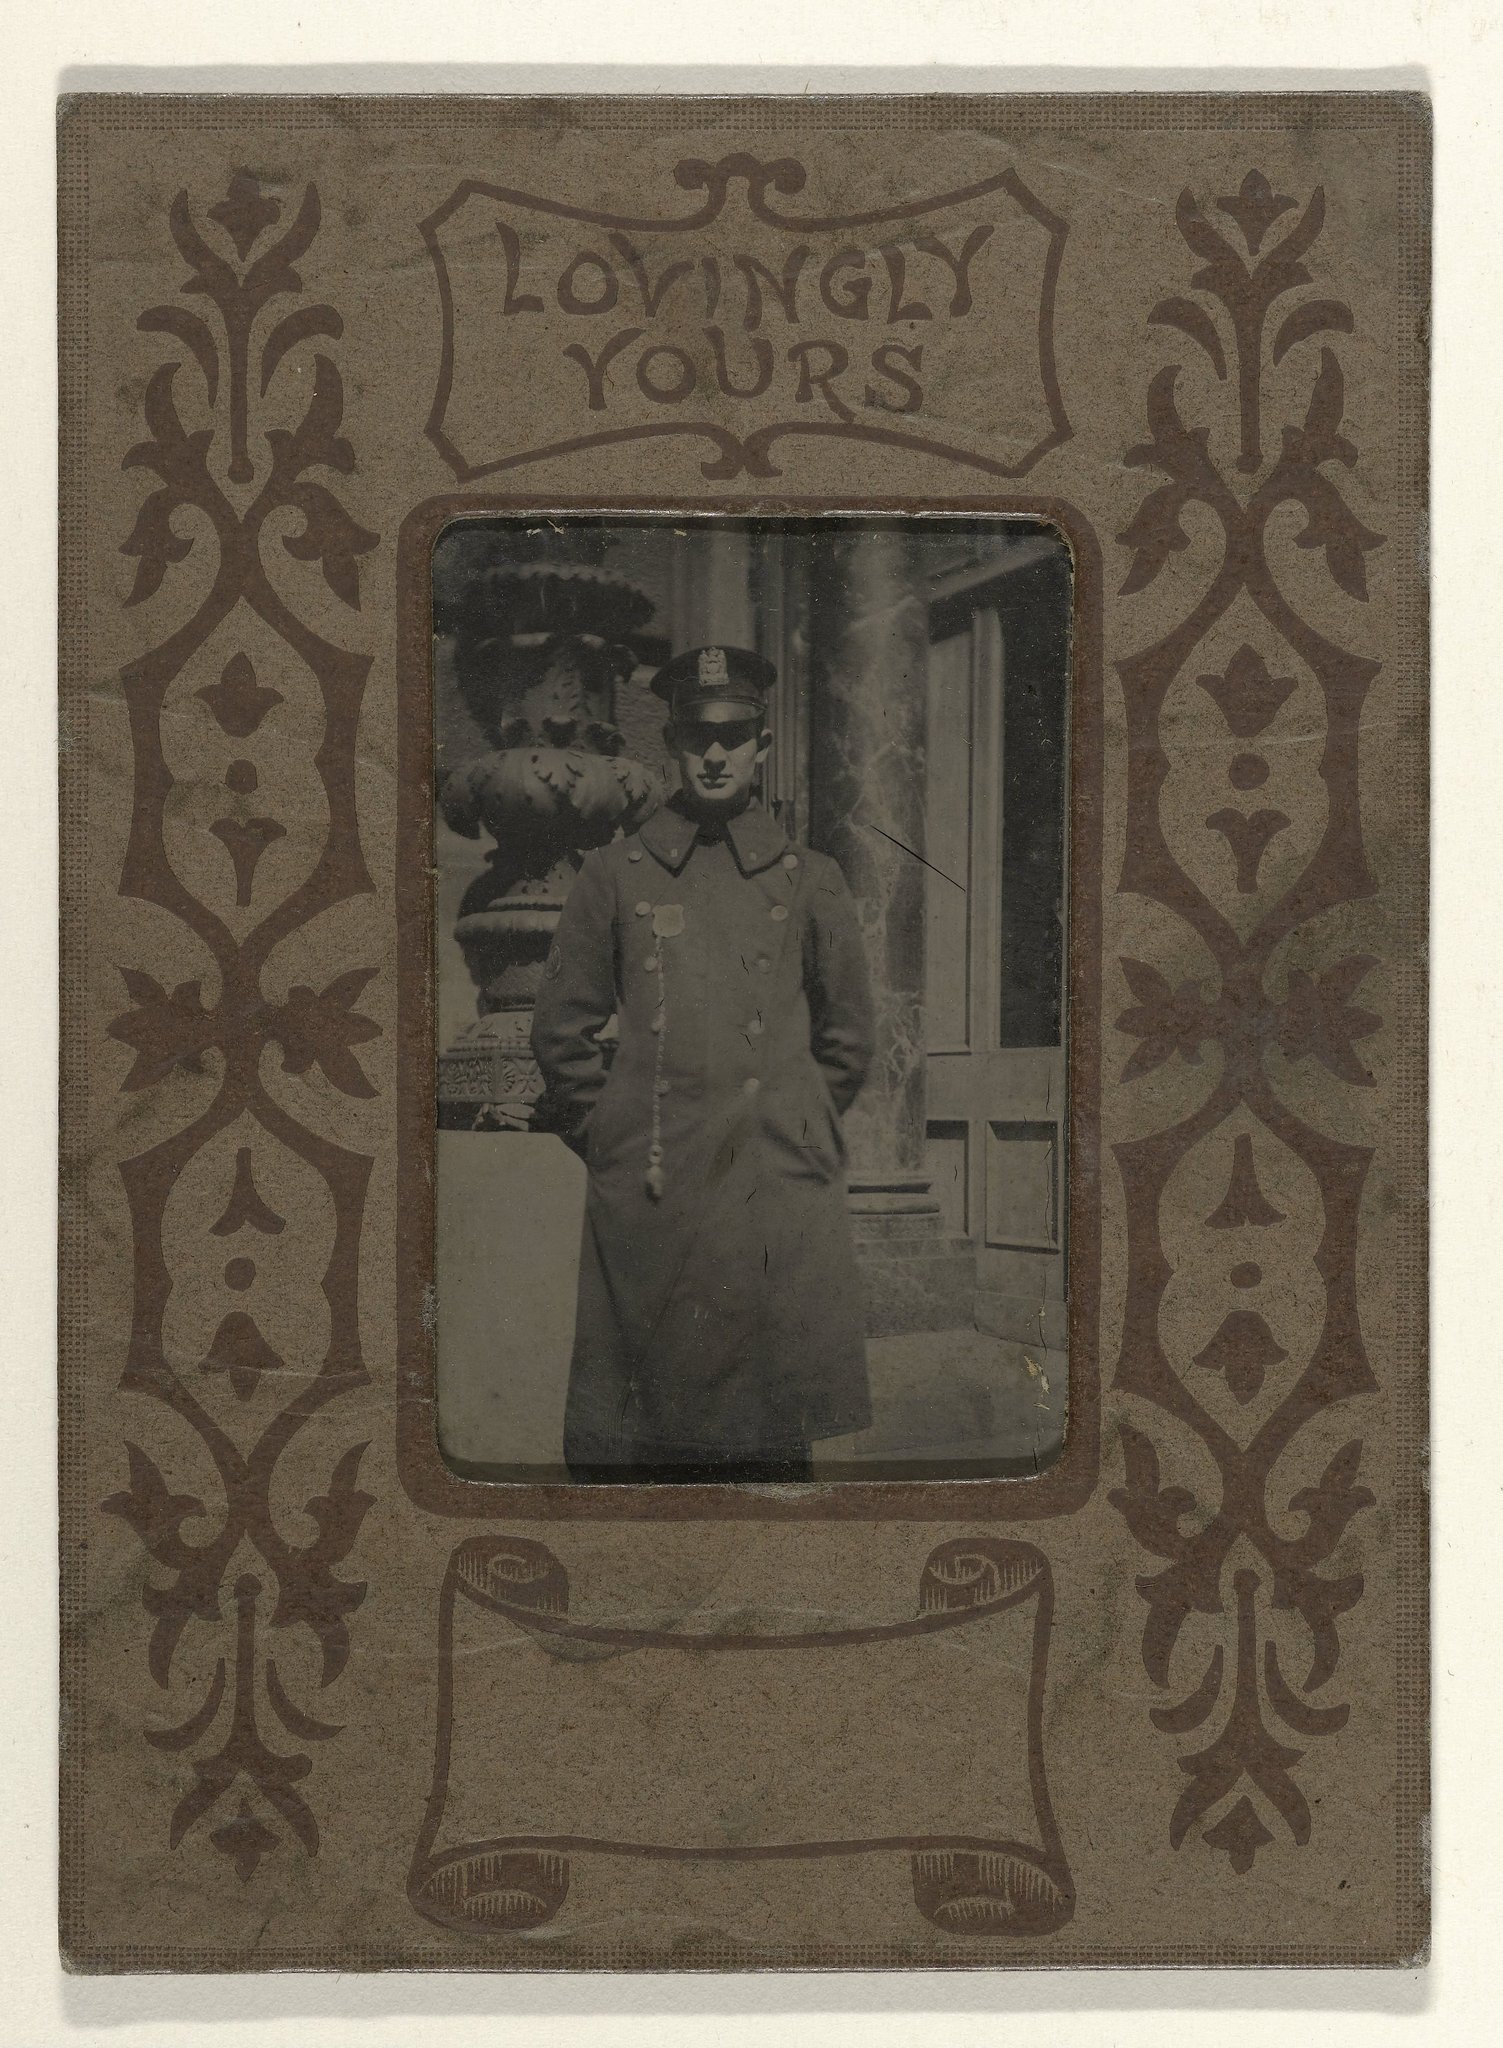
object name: photograph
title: Lovingly Yours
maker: Anonymous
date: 1900-1920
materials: metal, paper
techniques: ferrotyping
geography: north and central america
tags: historical persons not known by name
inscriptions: address: ‘LOVINGLY // YOURS’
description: Portret van een man in uniform, in een papieren passepartout met de tekst ‘LOVINGLY YOURS’. Onder de foto een cartouche met ruimte voor de naam van de voorgestelde (niet ingevuld).